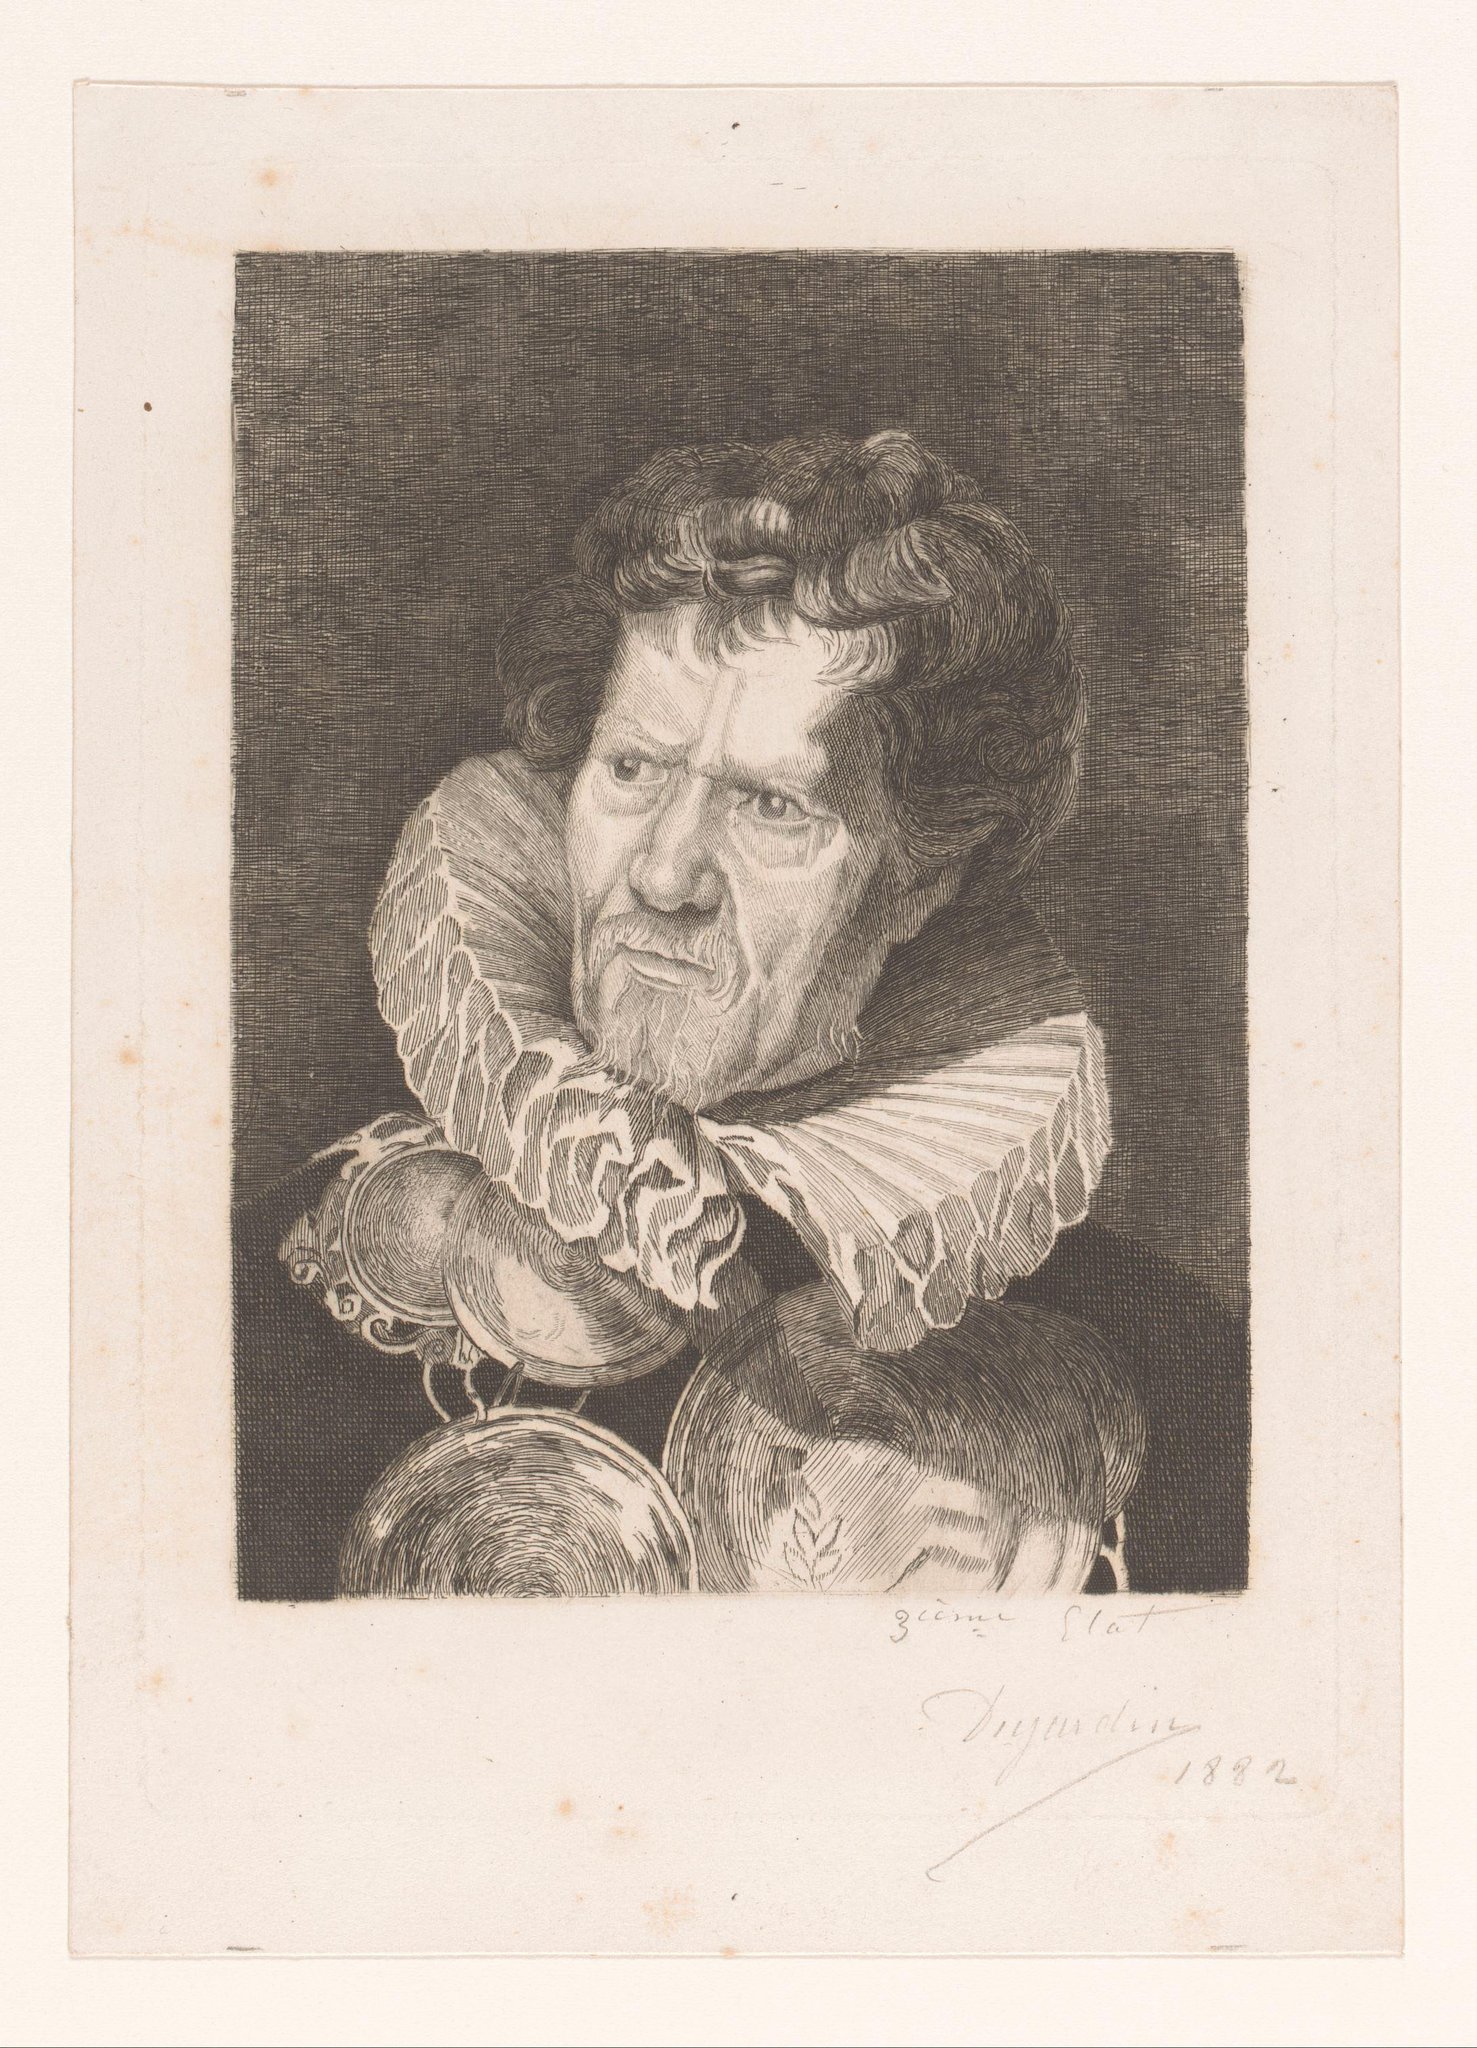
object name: print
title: Portret van Abraham Grapheus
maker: joseph dujardin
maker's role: print maker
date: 1882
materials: paper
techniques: etching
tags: adult man, historical persons, antwerp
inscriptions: inscription: ‘3 eme Etat’, collector's mark: Lugt 2228